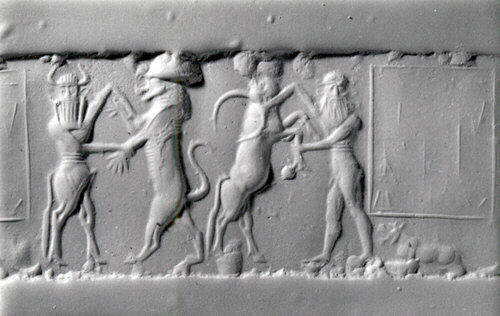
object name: cylinder seal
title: Cylinder seal and modern impression: heroes wrestling rampant animals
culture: akkadian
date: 2250-2150 BCE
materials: jasper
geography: mesopotamia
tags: animals,men